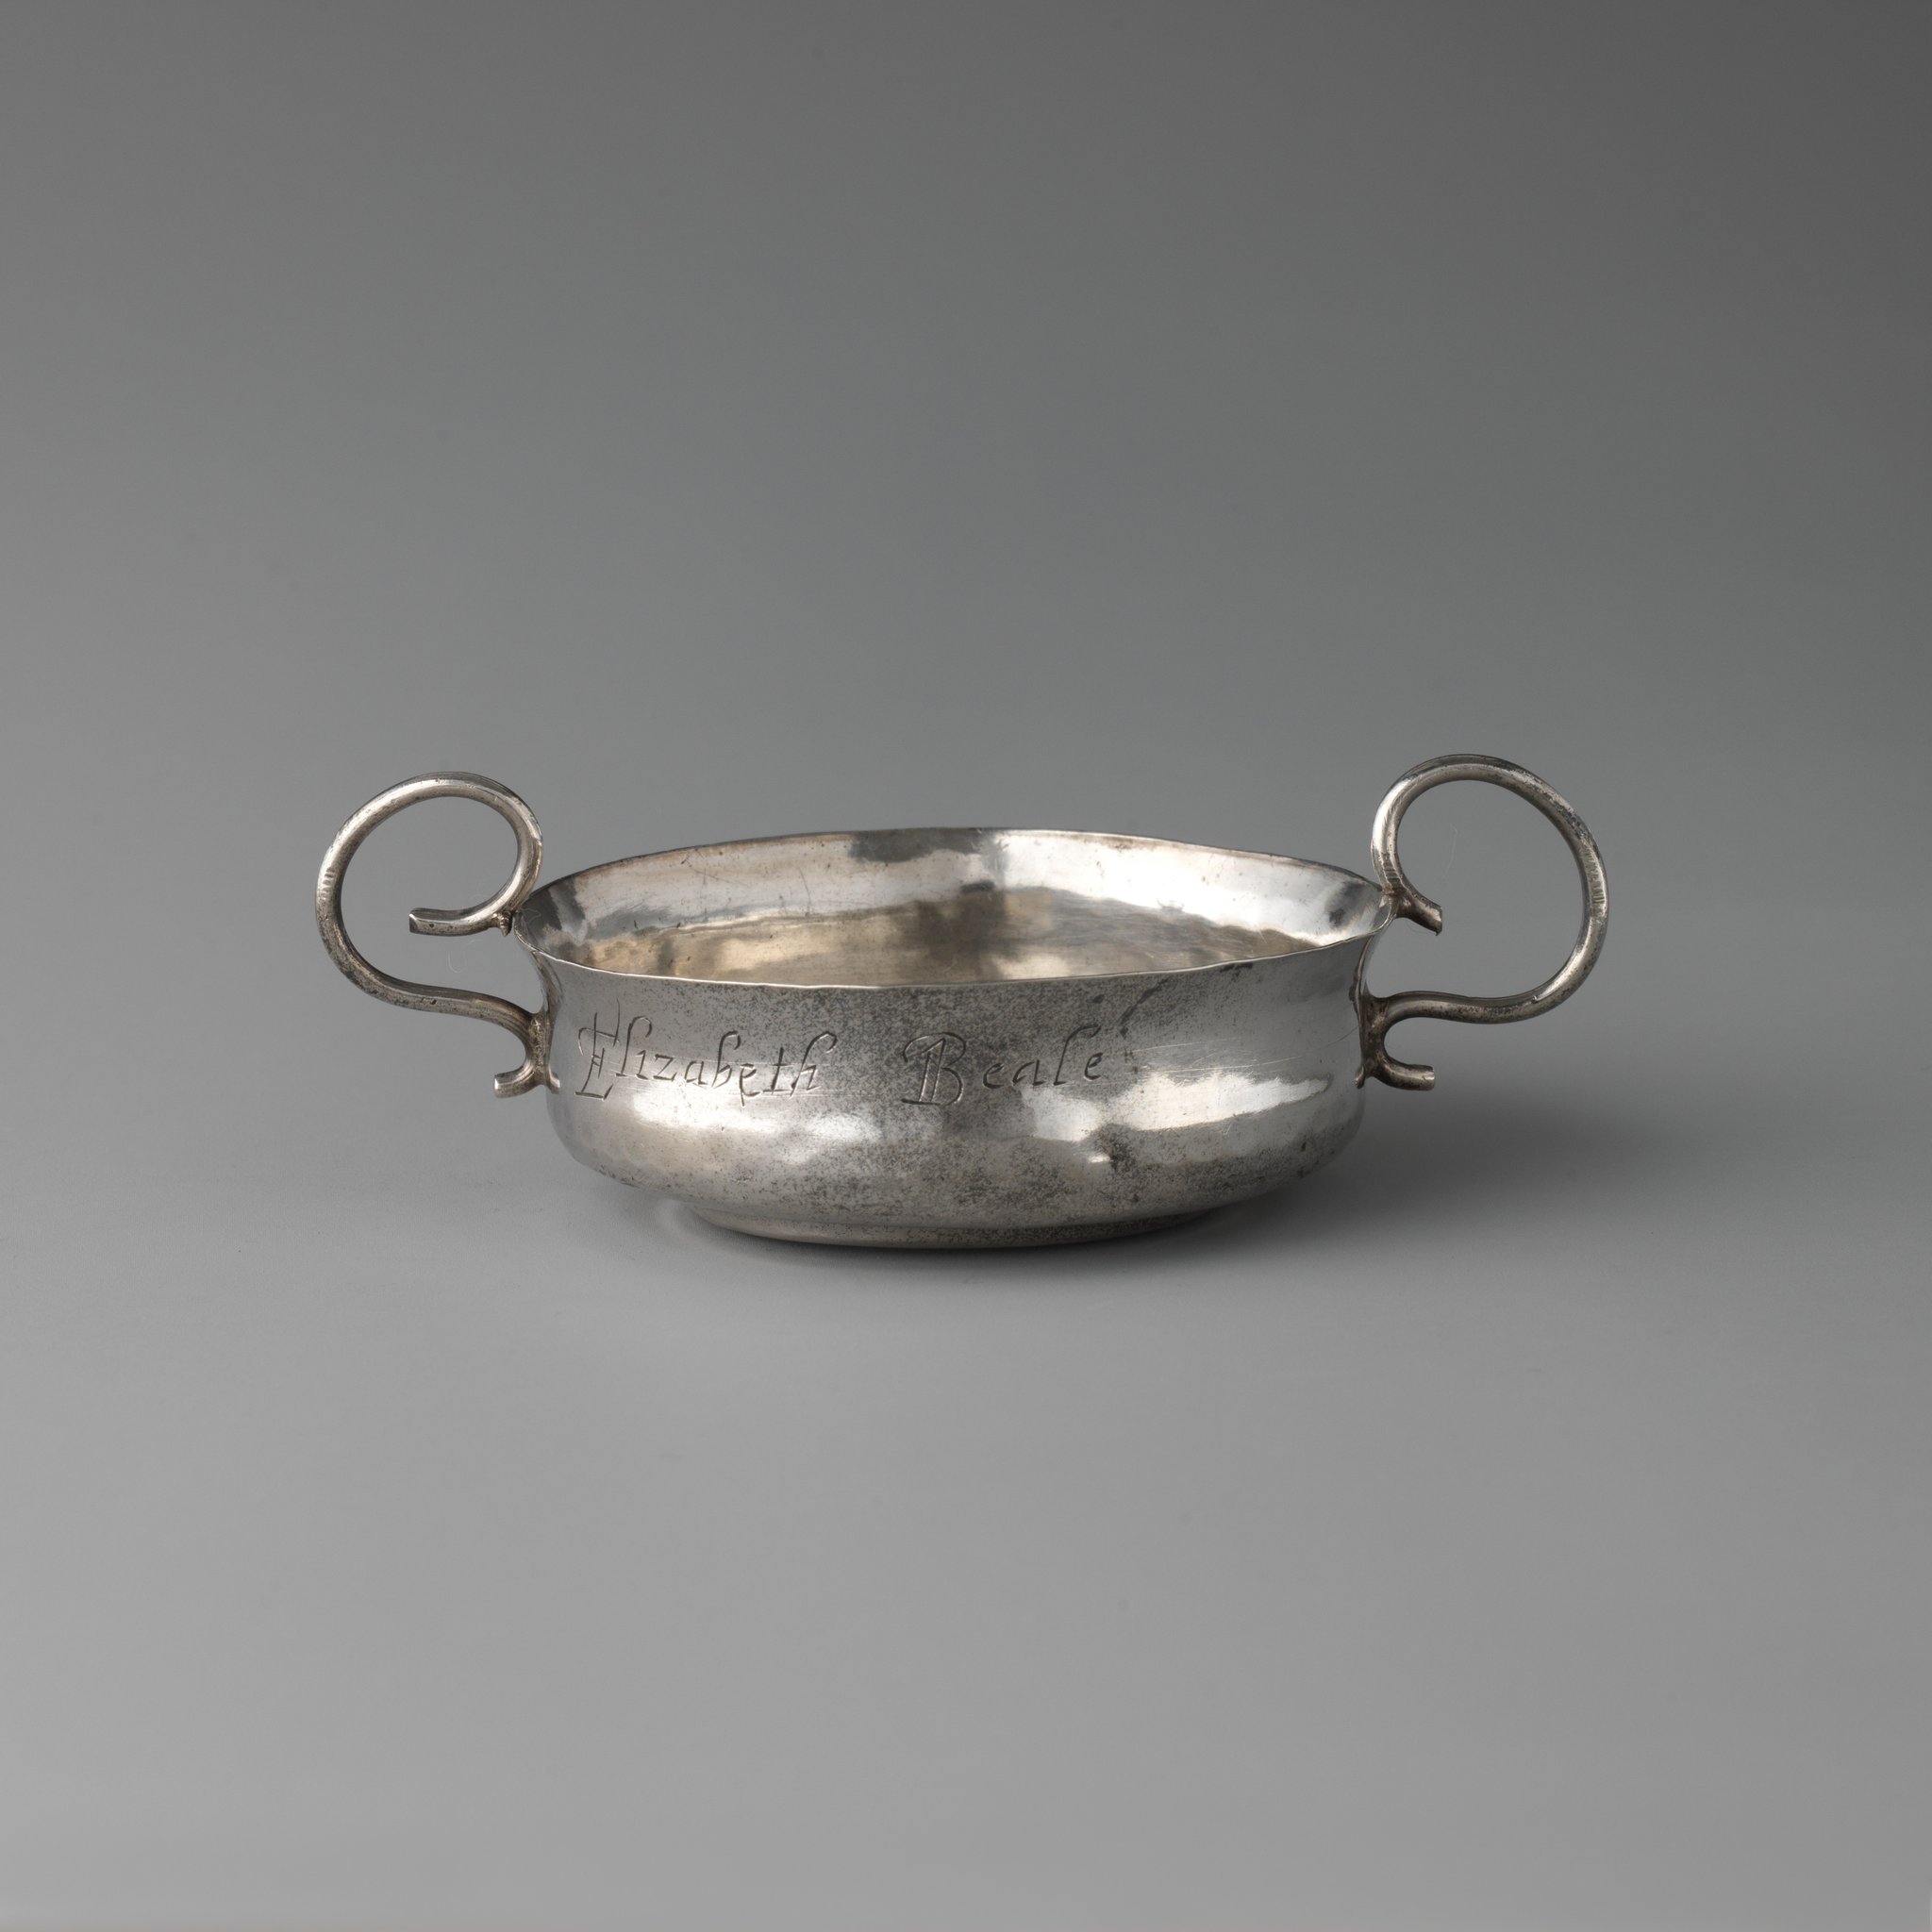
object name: wine taster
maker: s. h., london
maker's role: maker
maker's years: 1683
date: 1687-1688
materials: silver